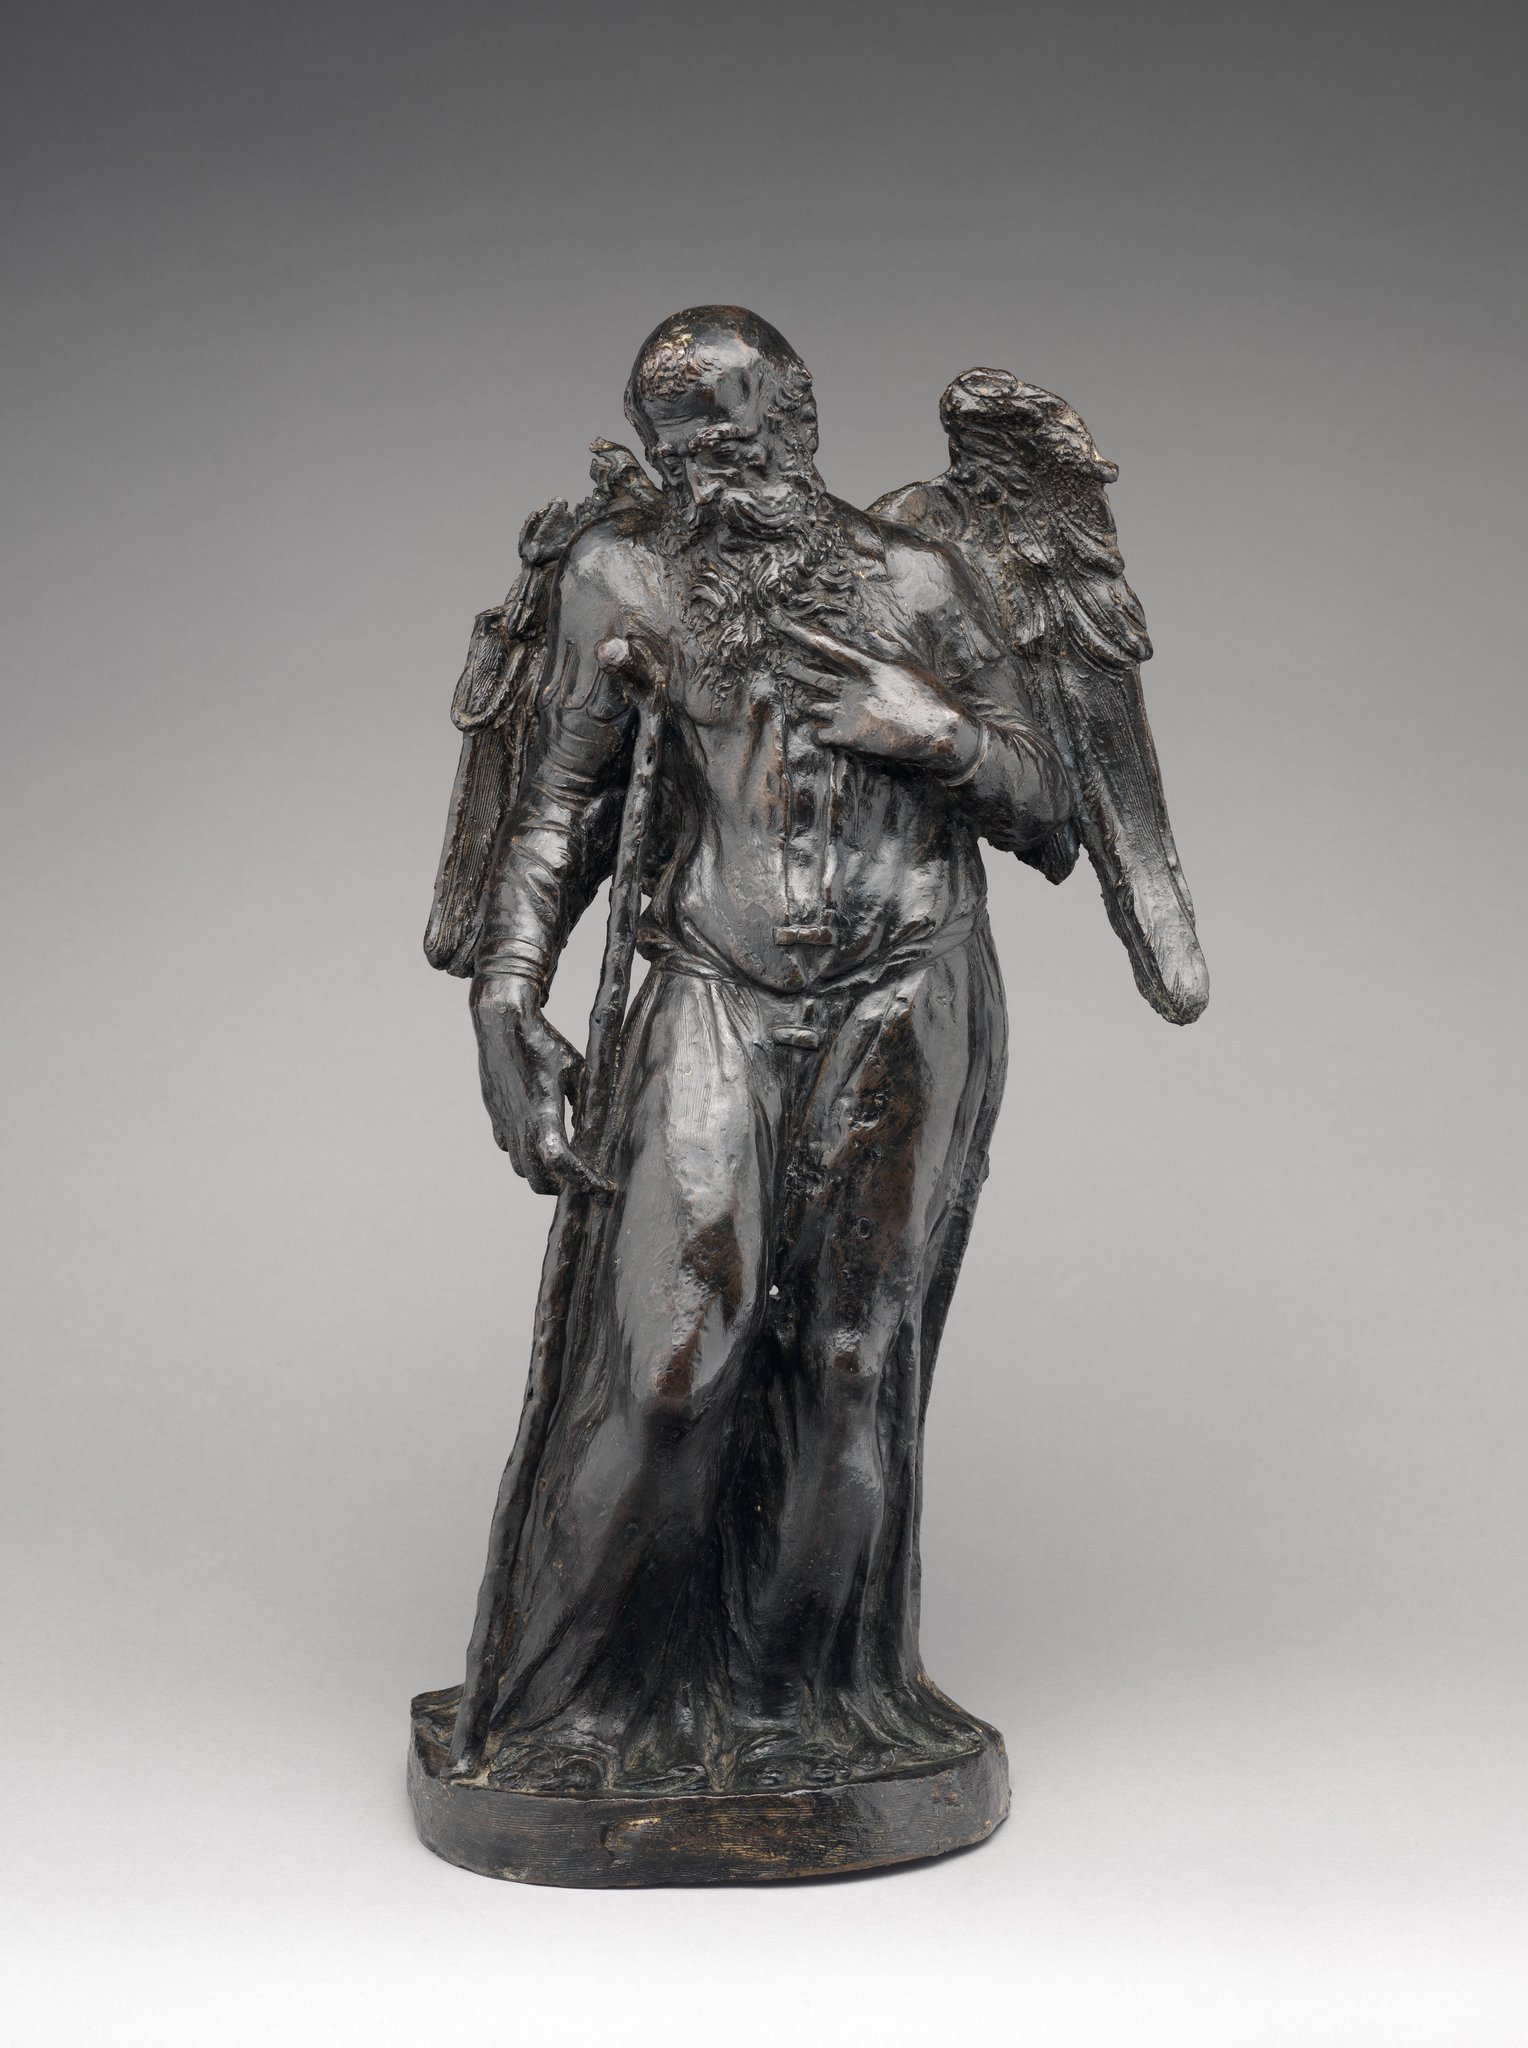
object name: statuette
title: Chronos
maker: agostino zoppo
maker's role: artist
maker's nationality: italian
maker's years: 1515-1572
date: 1534-1566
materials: bronze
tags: men